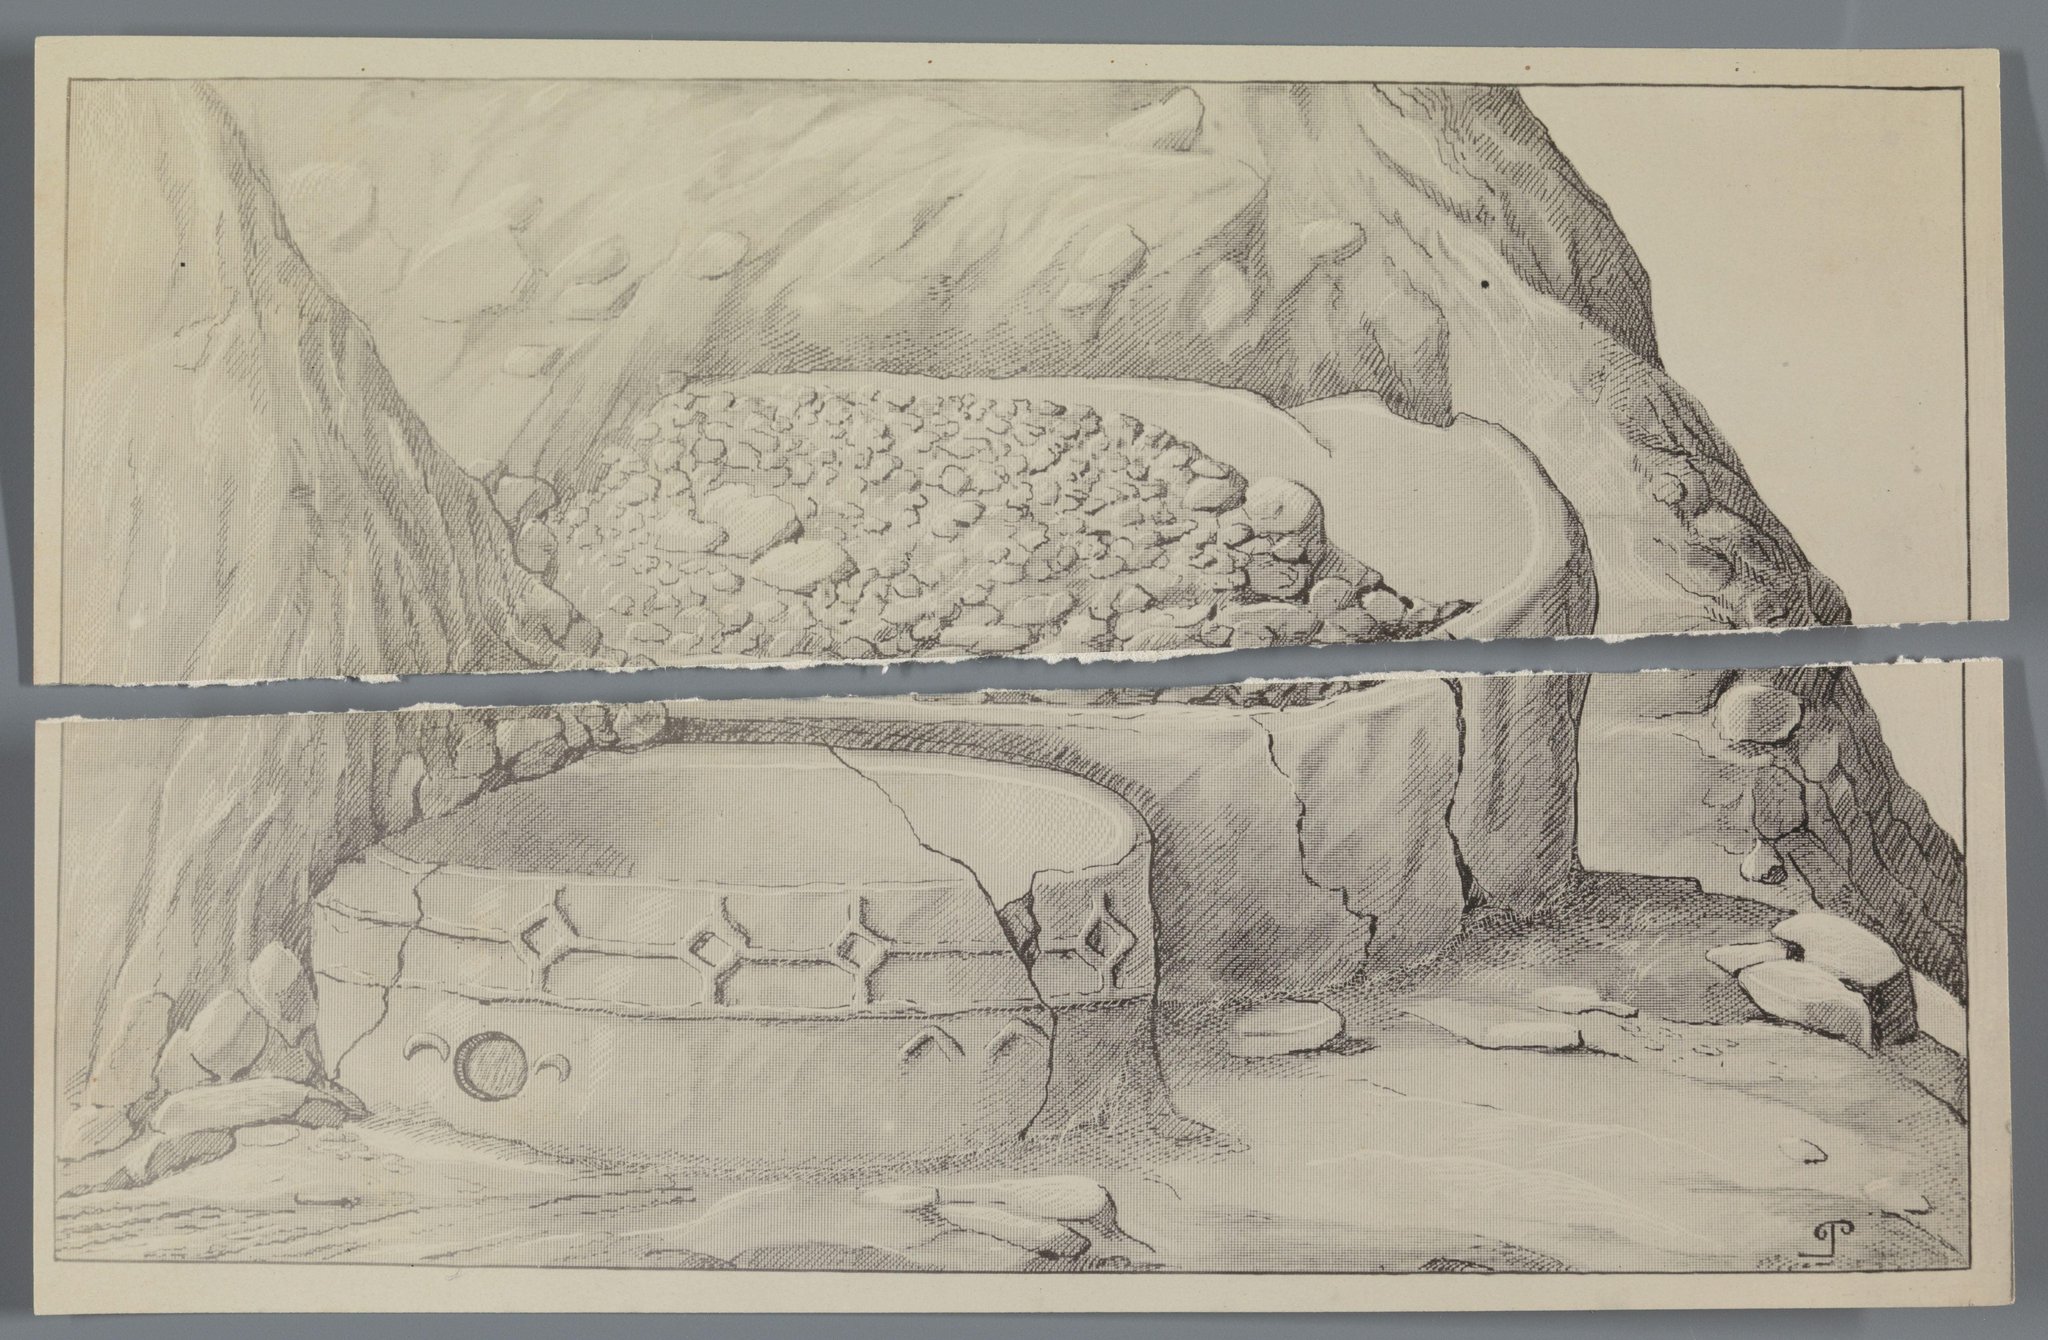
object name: reproduction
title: Vuurhaard uit Toszeg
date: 1928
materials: paper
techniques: gelatin silver print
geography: tószeg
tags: excavation ~ archaeology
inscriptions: inscription: ‘Vuurhaard uit Toszeg’